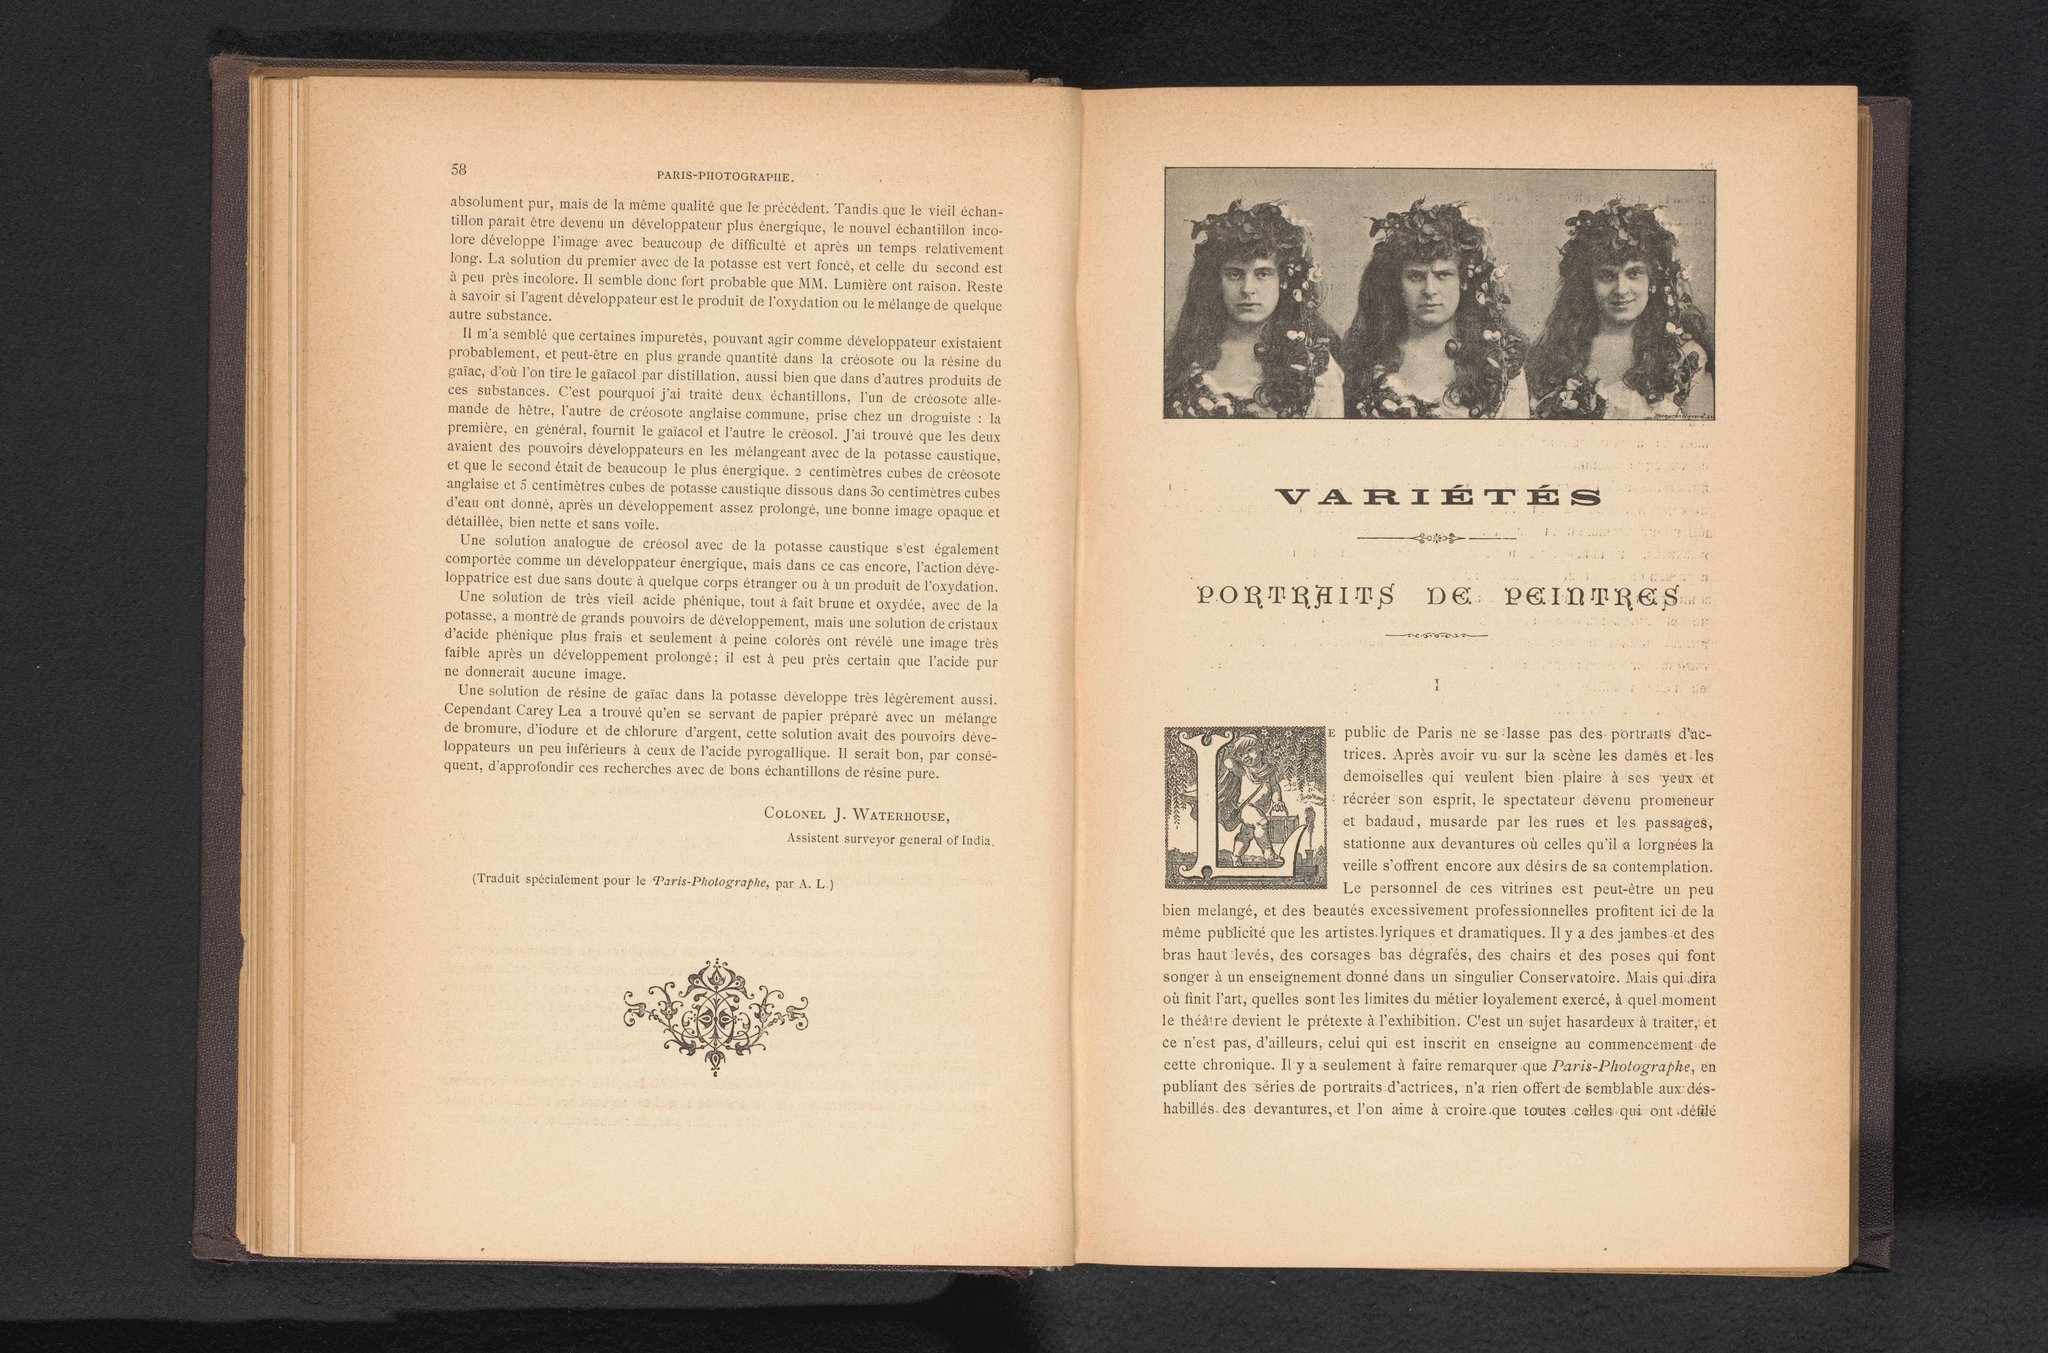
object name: photomechanical print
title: Drie portretten van een onbekende vrouw die verschillende emoties toont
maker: Anonymous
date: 1883-1893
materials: paper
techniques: autotype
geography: france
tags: passions, emotions, affections, adult woman